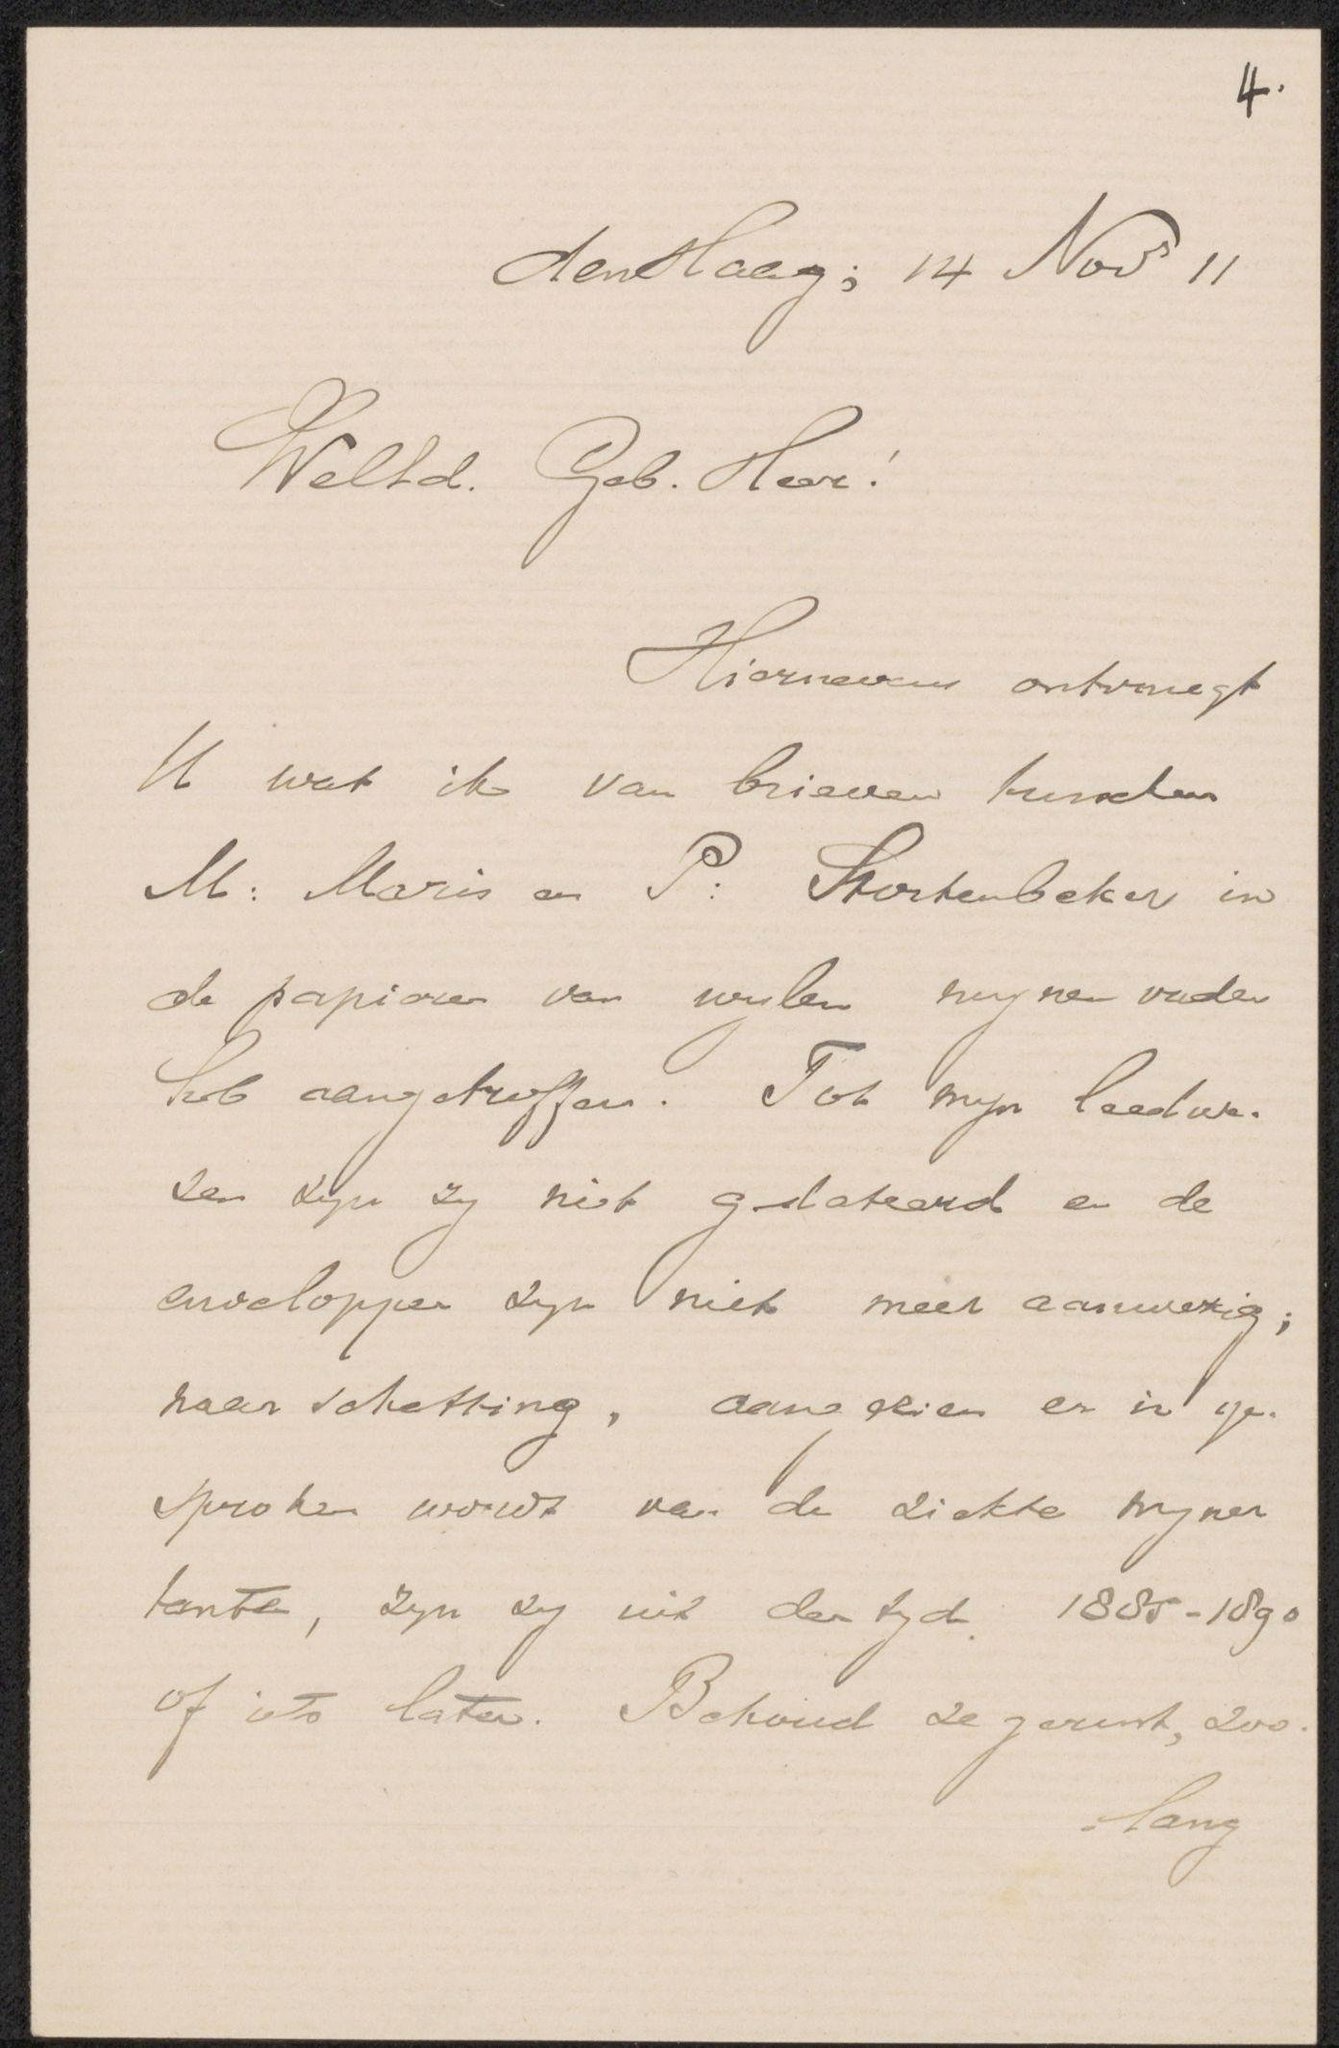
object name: letter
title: Brief aan Pieter Haverkorn van Rijsewijk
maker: w. stortenbeker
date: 1911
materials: ink, paper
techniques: pen, writing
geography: the hague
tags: pieter stortenbeker, london, painter, print maker, draughtsman, matthijs maris, pieter haverkorn van rijsewijk, art trade, art shop, painting (including book-illumination, miniature-painting)